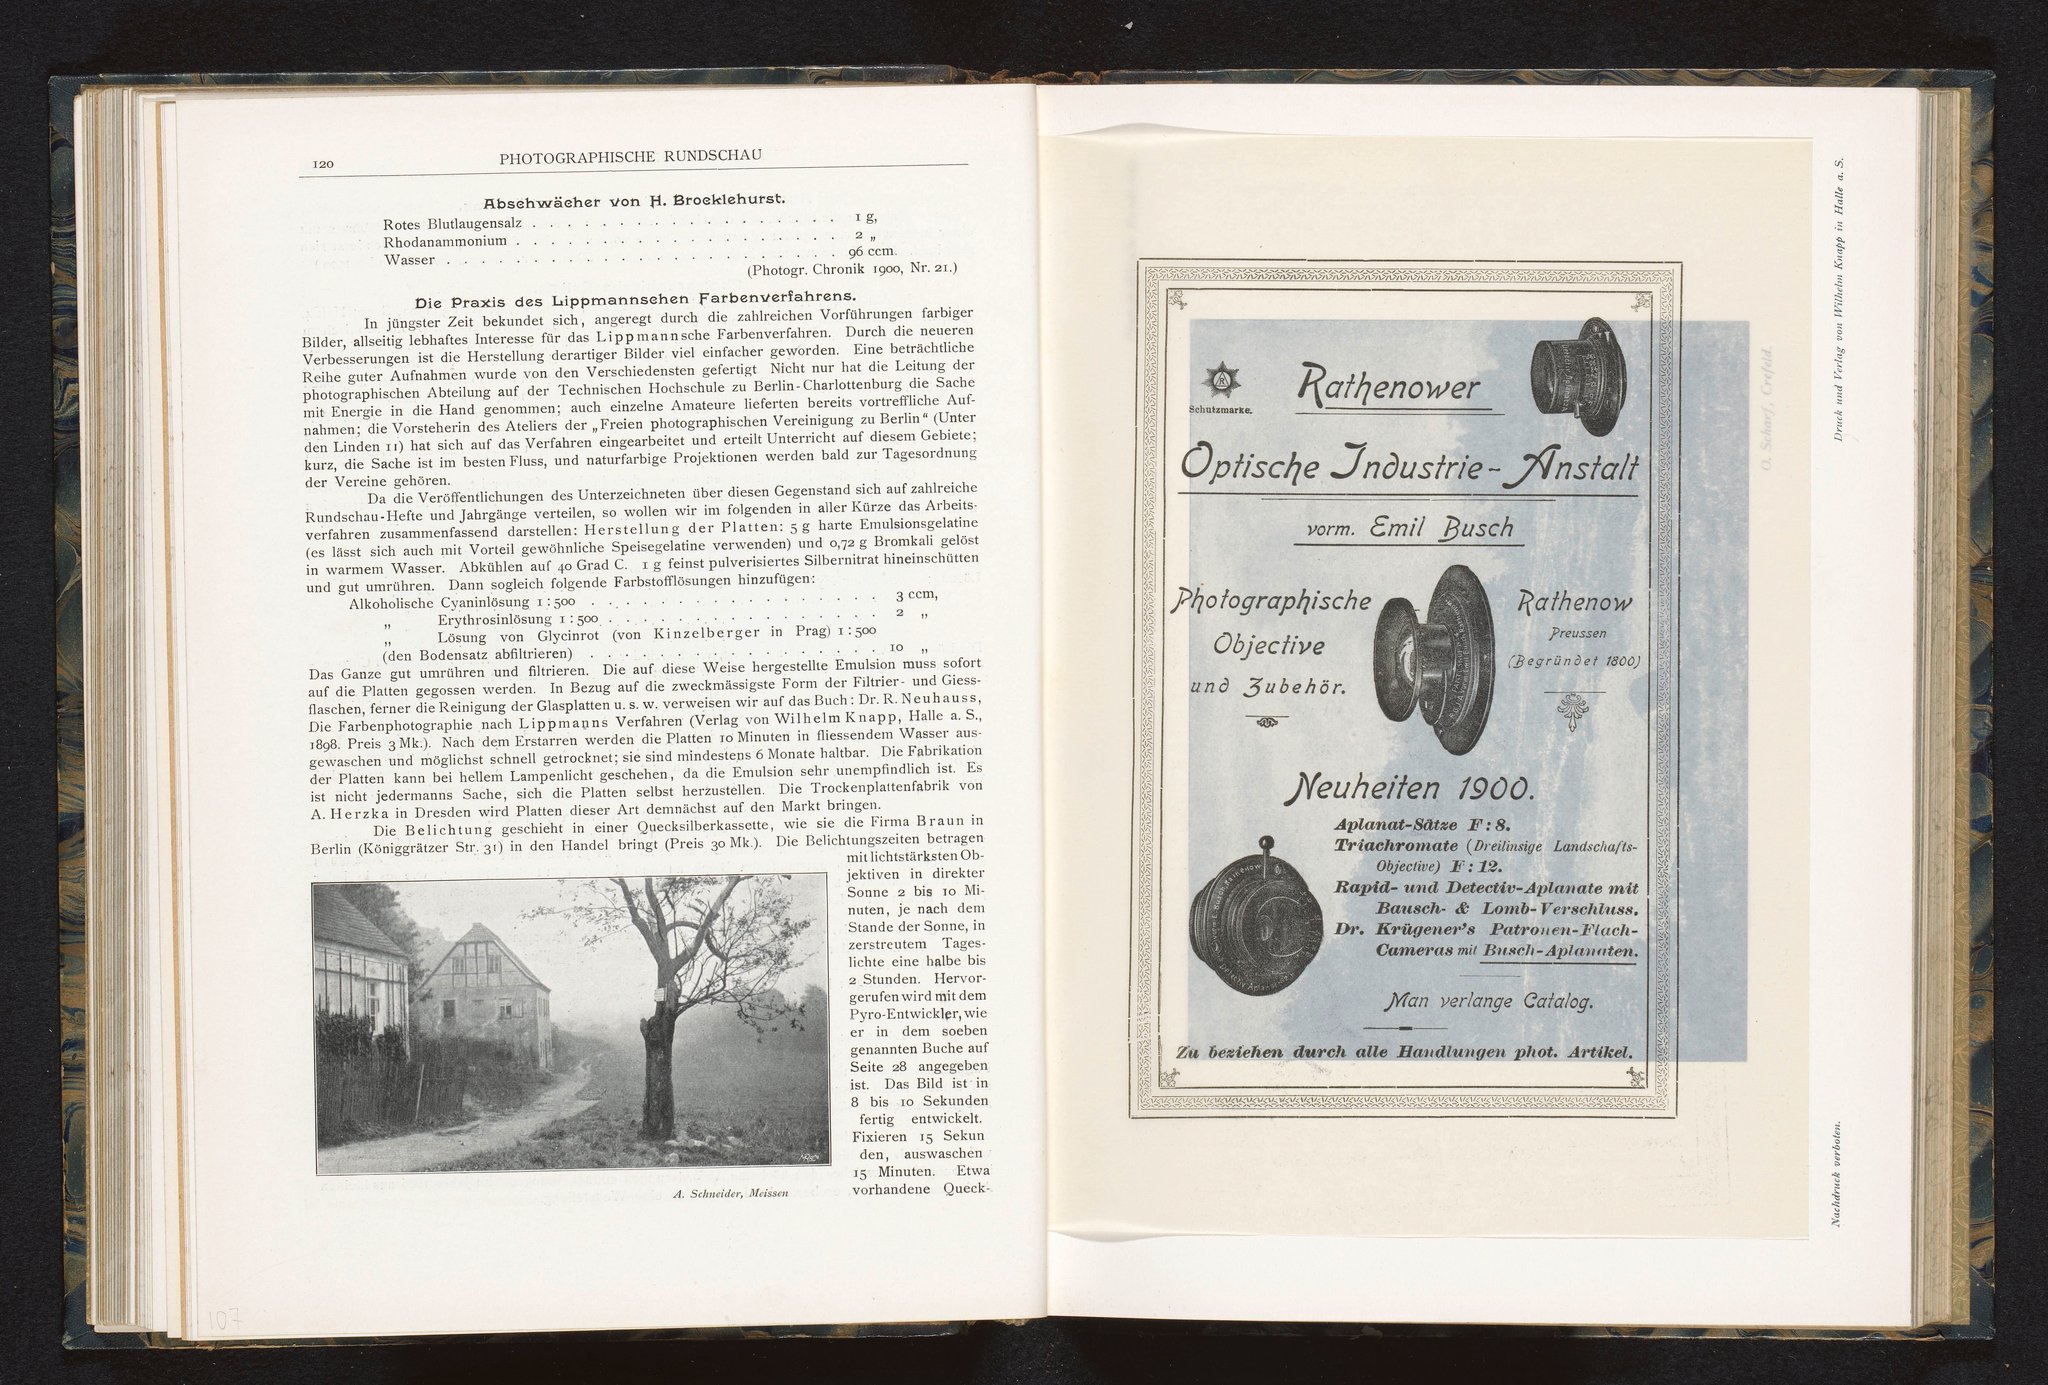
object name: page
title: Gezicht op een pad langs twee huizen en een boom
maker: alfred schneider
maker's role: fotograaf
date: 1895-1900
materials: paper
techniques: autotype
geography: berlin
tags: trees, rural housing, e.g. country-house, villa, cottage, road, path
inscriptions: monogram: ‘MR&Co’